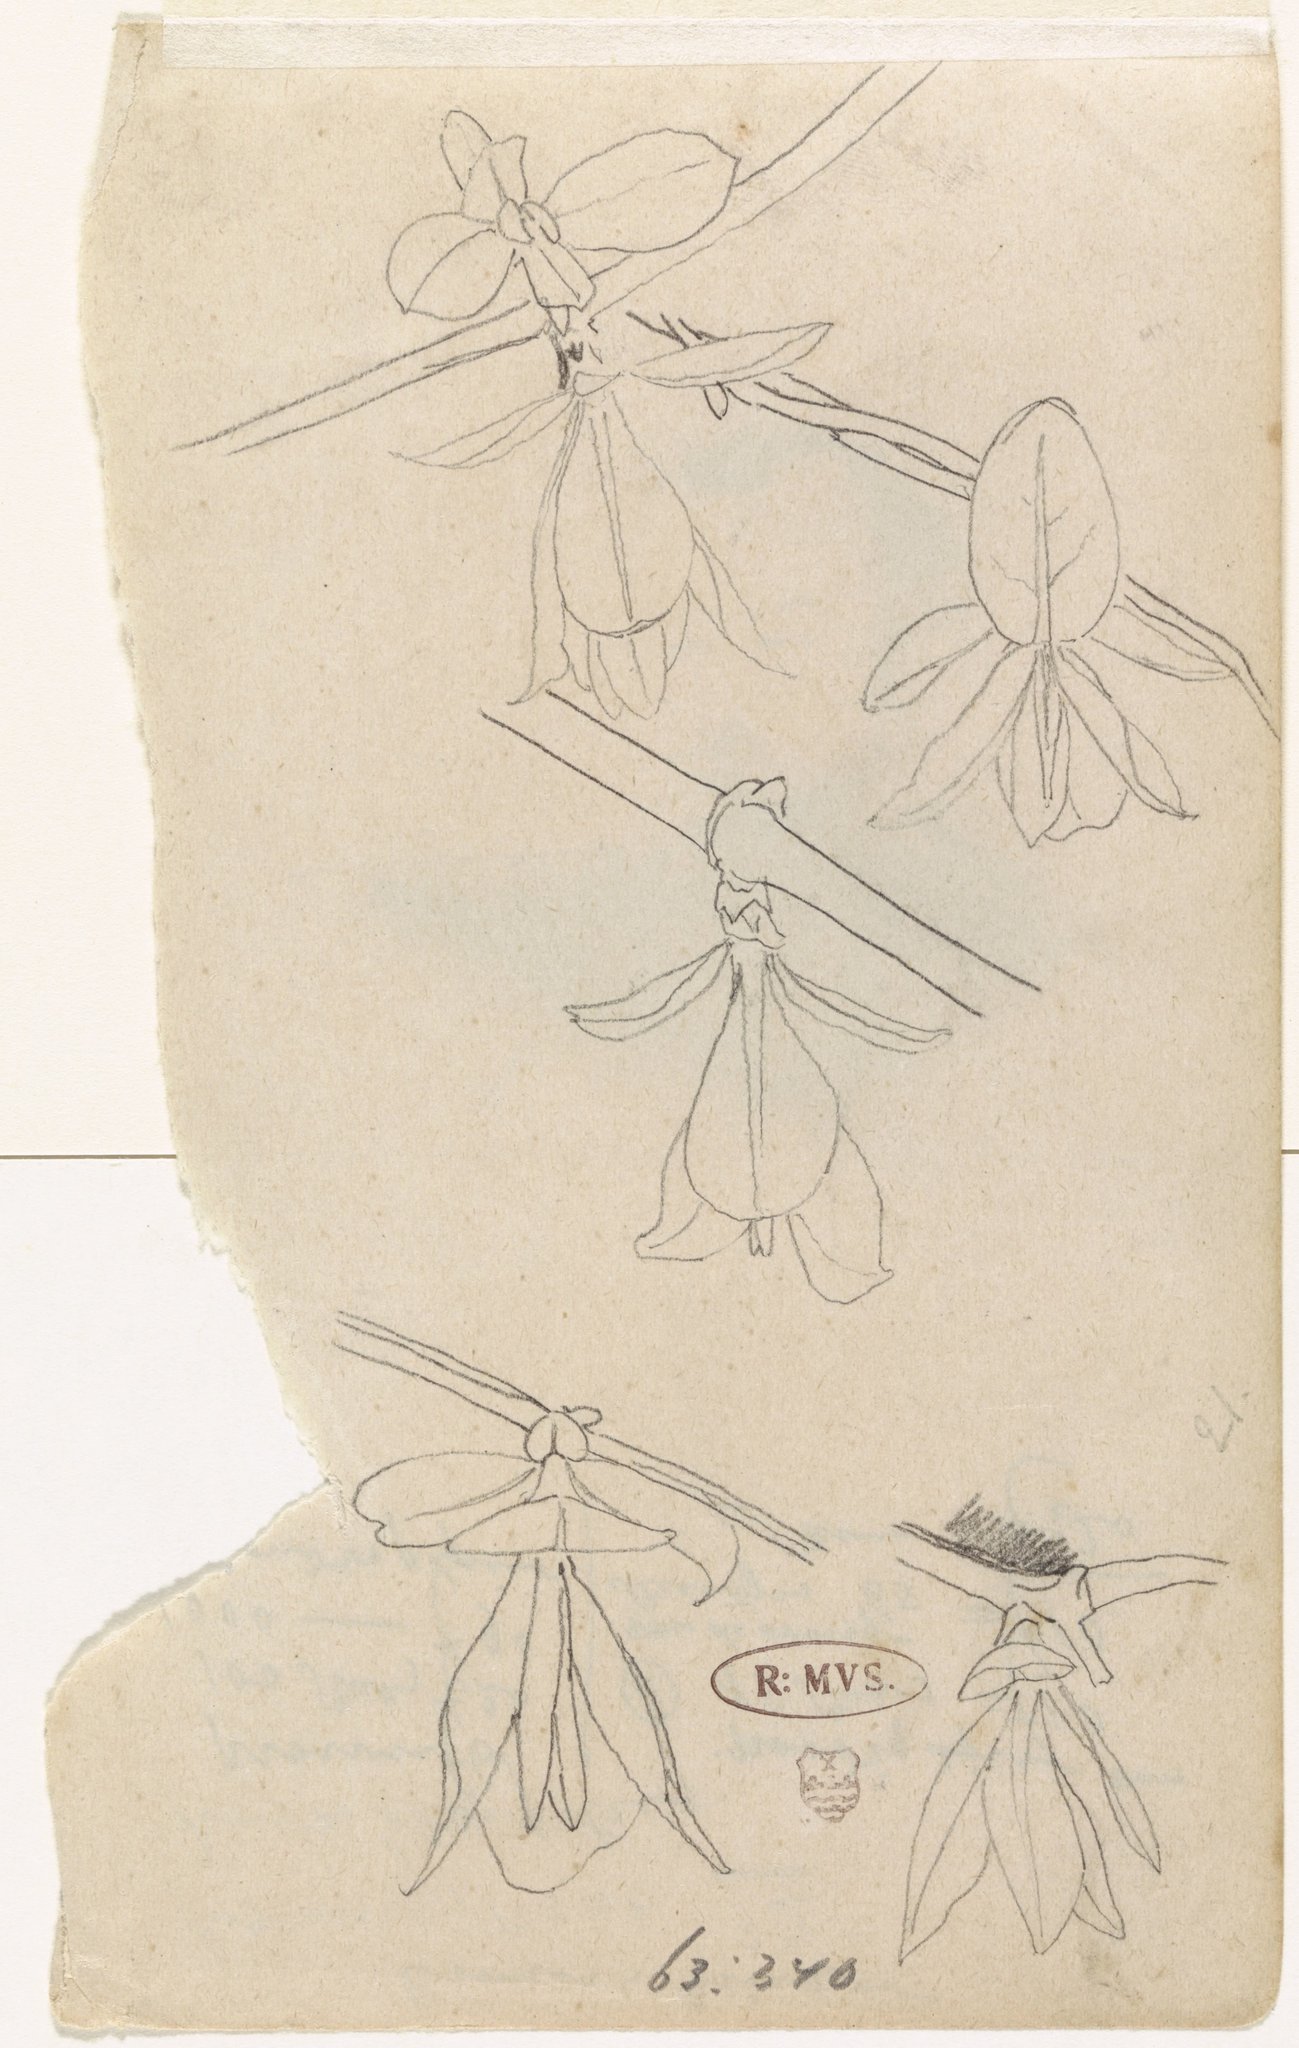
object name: drawing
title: Studies van de bloem van de magnolia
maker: gerrit willem dijsselhof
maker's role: designer, draughtsman, print maker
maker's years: 1866-1924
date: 1876-1924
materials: chalk, paper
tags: flowers: magnolia